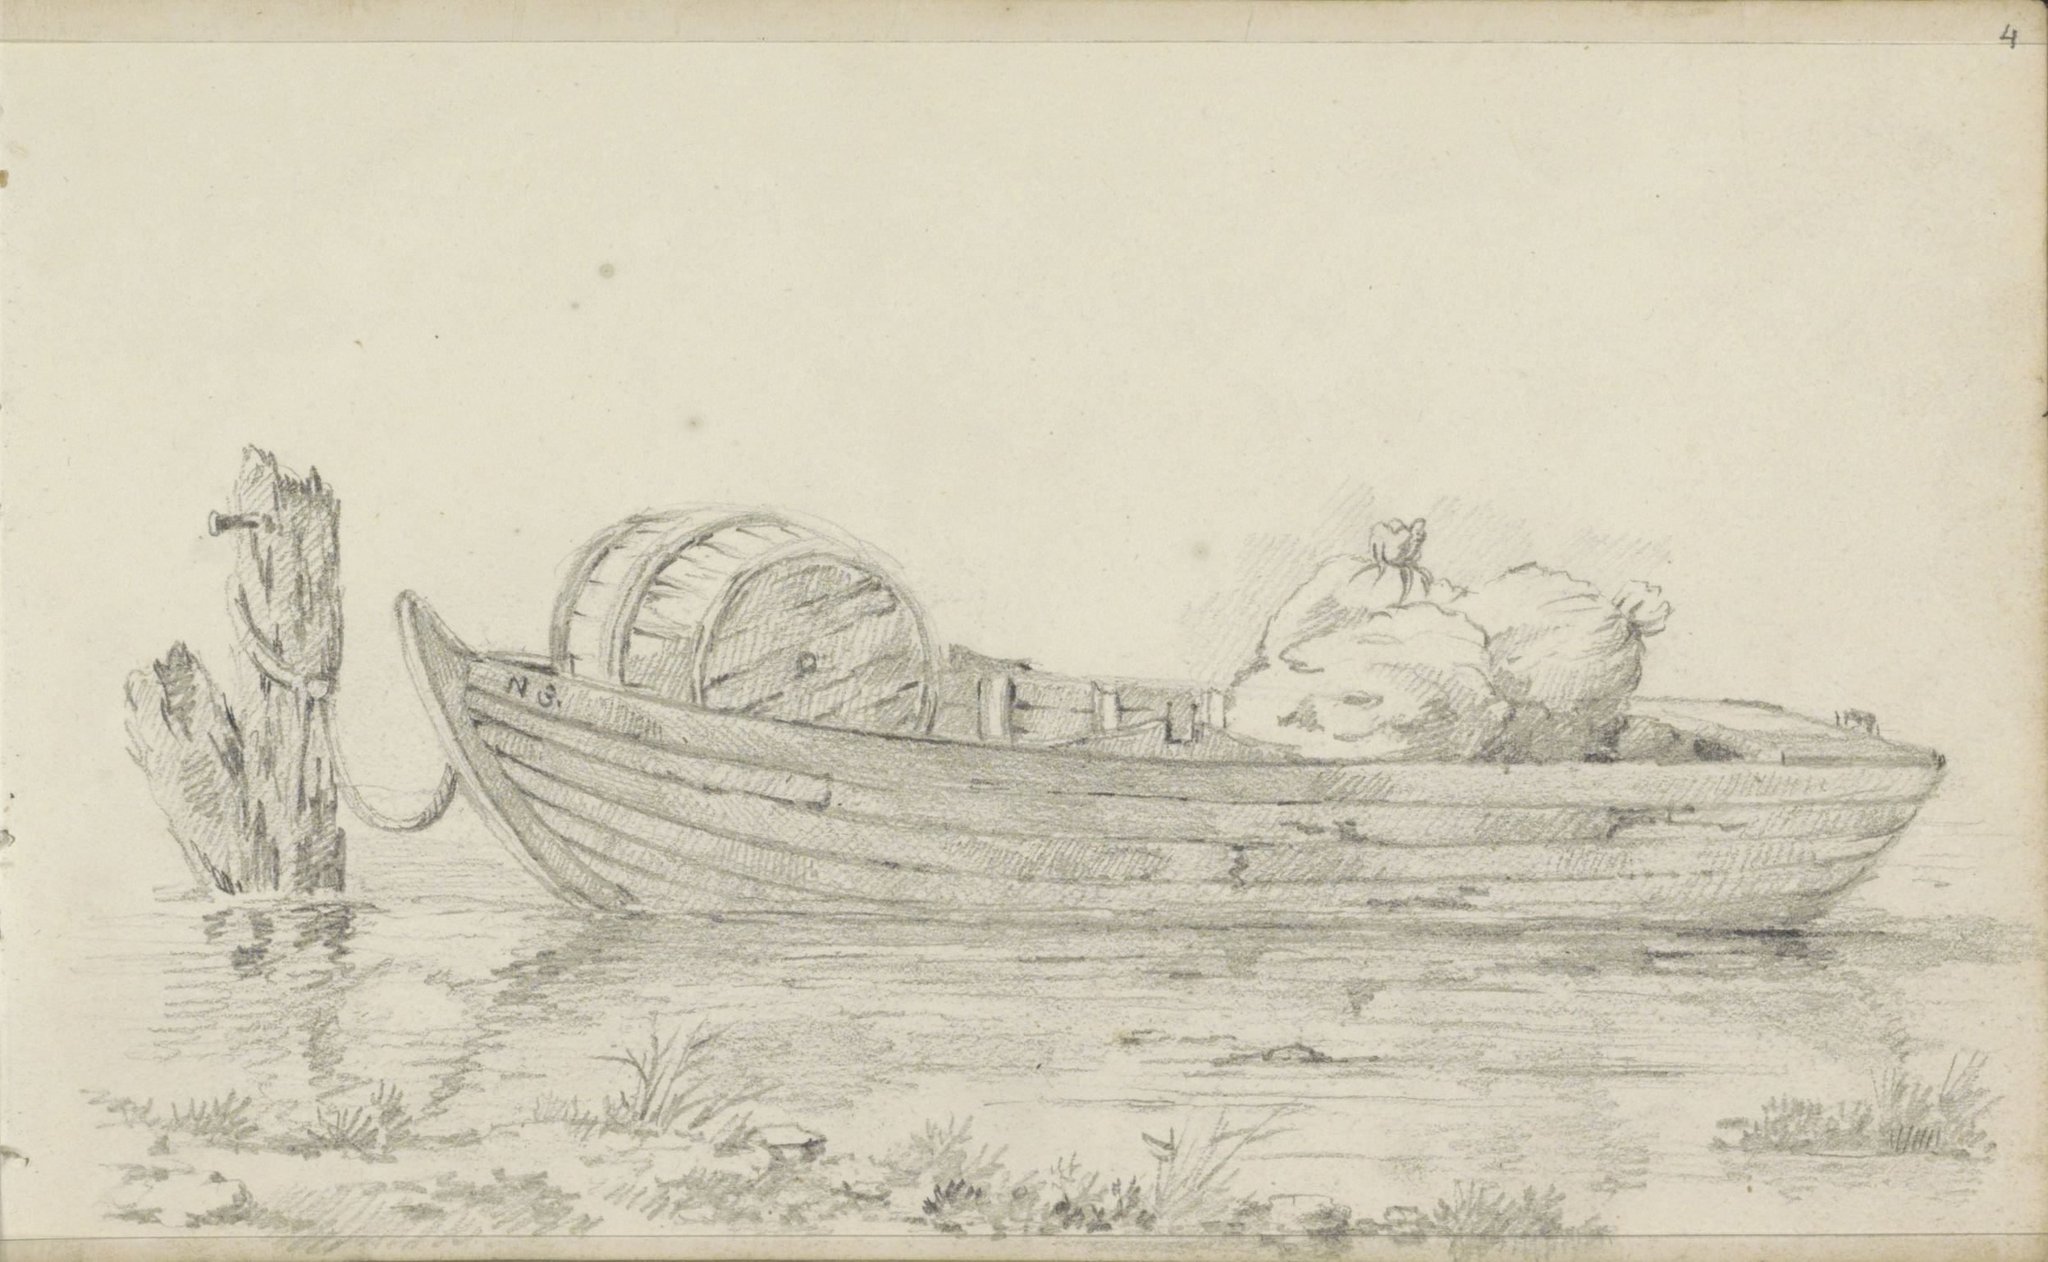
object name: sketchbook leaf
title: Roeiboot met goederen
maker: adrianus eversen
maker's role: draughtsman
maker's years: 1818-1897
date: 1828-1897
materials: paper, pencil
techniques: stumping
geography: netherlands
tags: wooden container: barrel, cask, bucket, rowing-boat, canoe, etc., container of textile material: bag, sack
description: Aangemeerde roeiboot met goederen in zakken en tonnen. Blad 4 recto uit een schetsboek met 27 bladen.